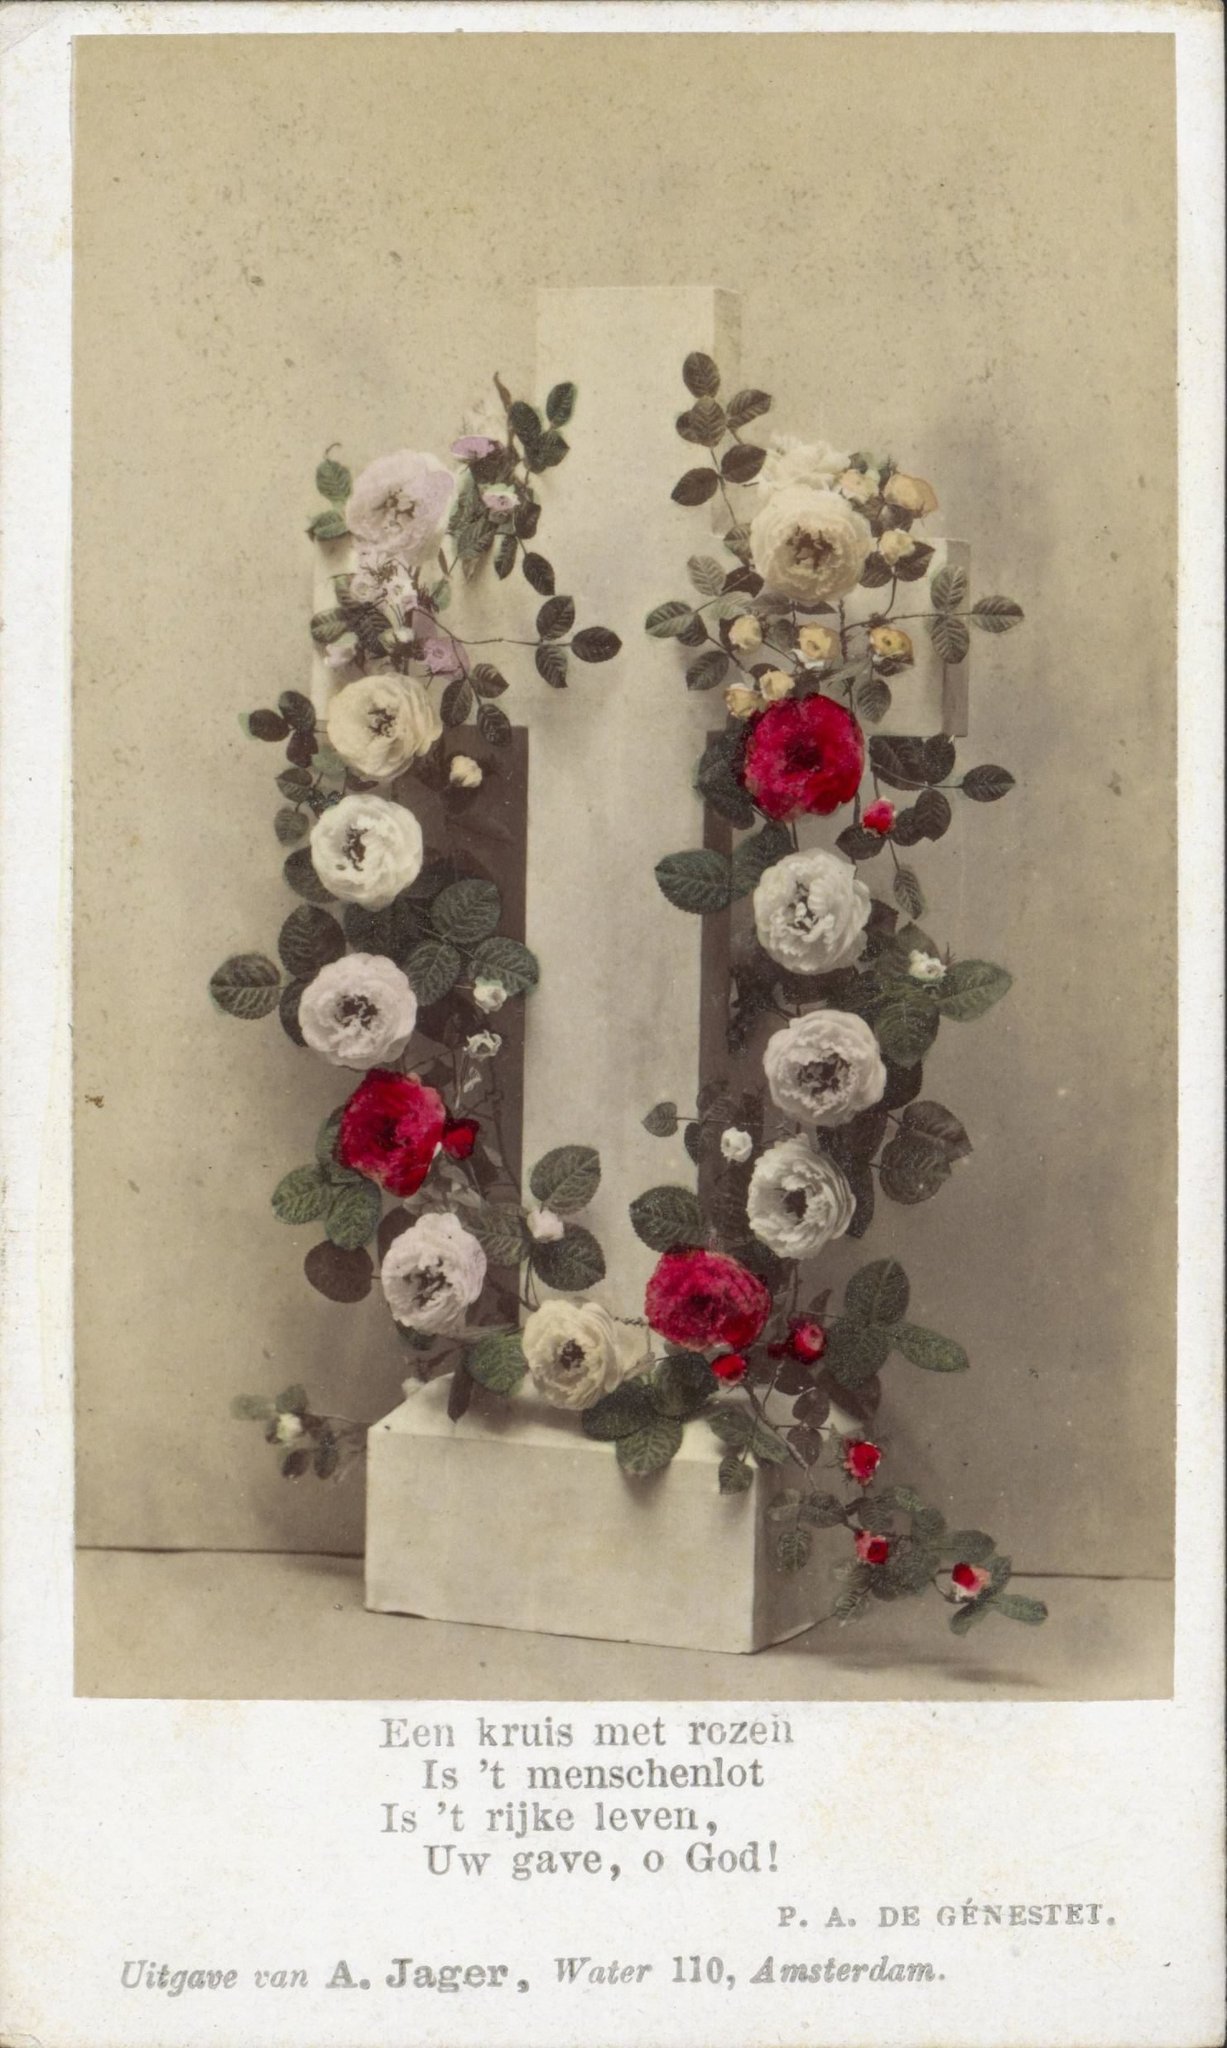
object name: photograph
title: Fotoreproductie van (vermoedelijk) een tekening van een met een bloemenkrans versierd kruis met daaronder dichtregels van P.A. de Génestet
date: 1870-1890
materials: cardboard, paper, photographic support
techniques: albumen print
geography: amsterdam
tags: the cross ~ symbols of christ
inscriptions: inscription: ‘Een kruis met rozen / Is 't menschenlot / Is 't rijke leven, / Uw gave, o God! P.A. de Génestet’